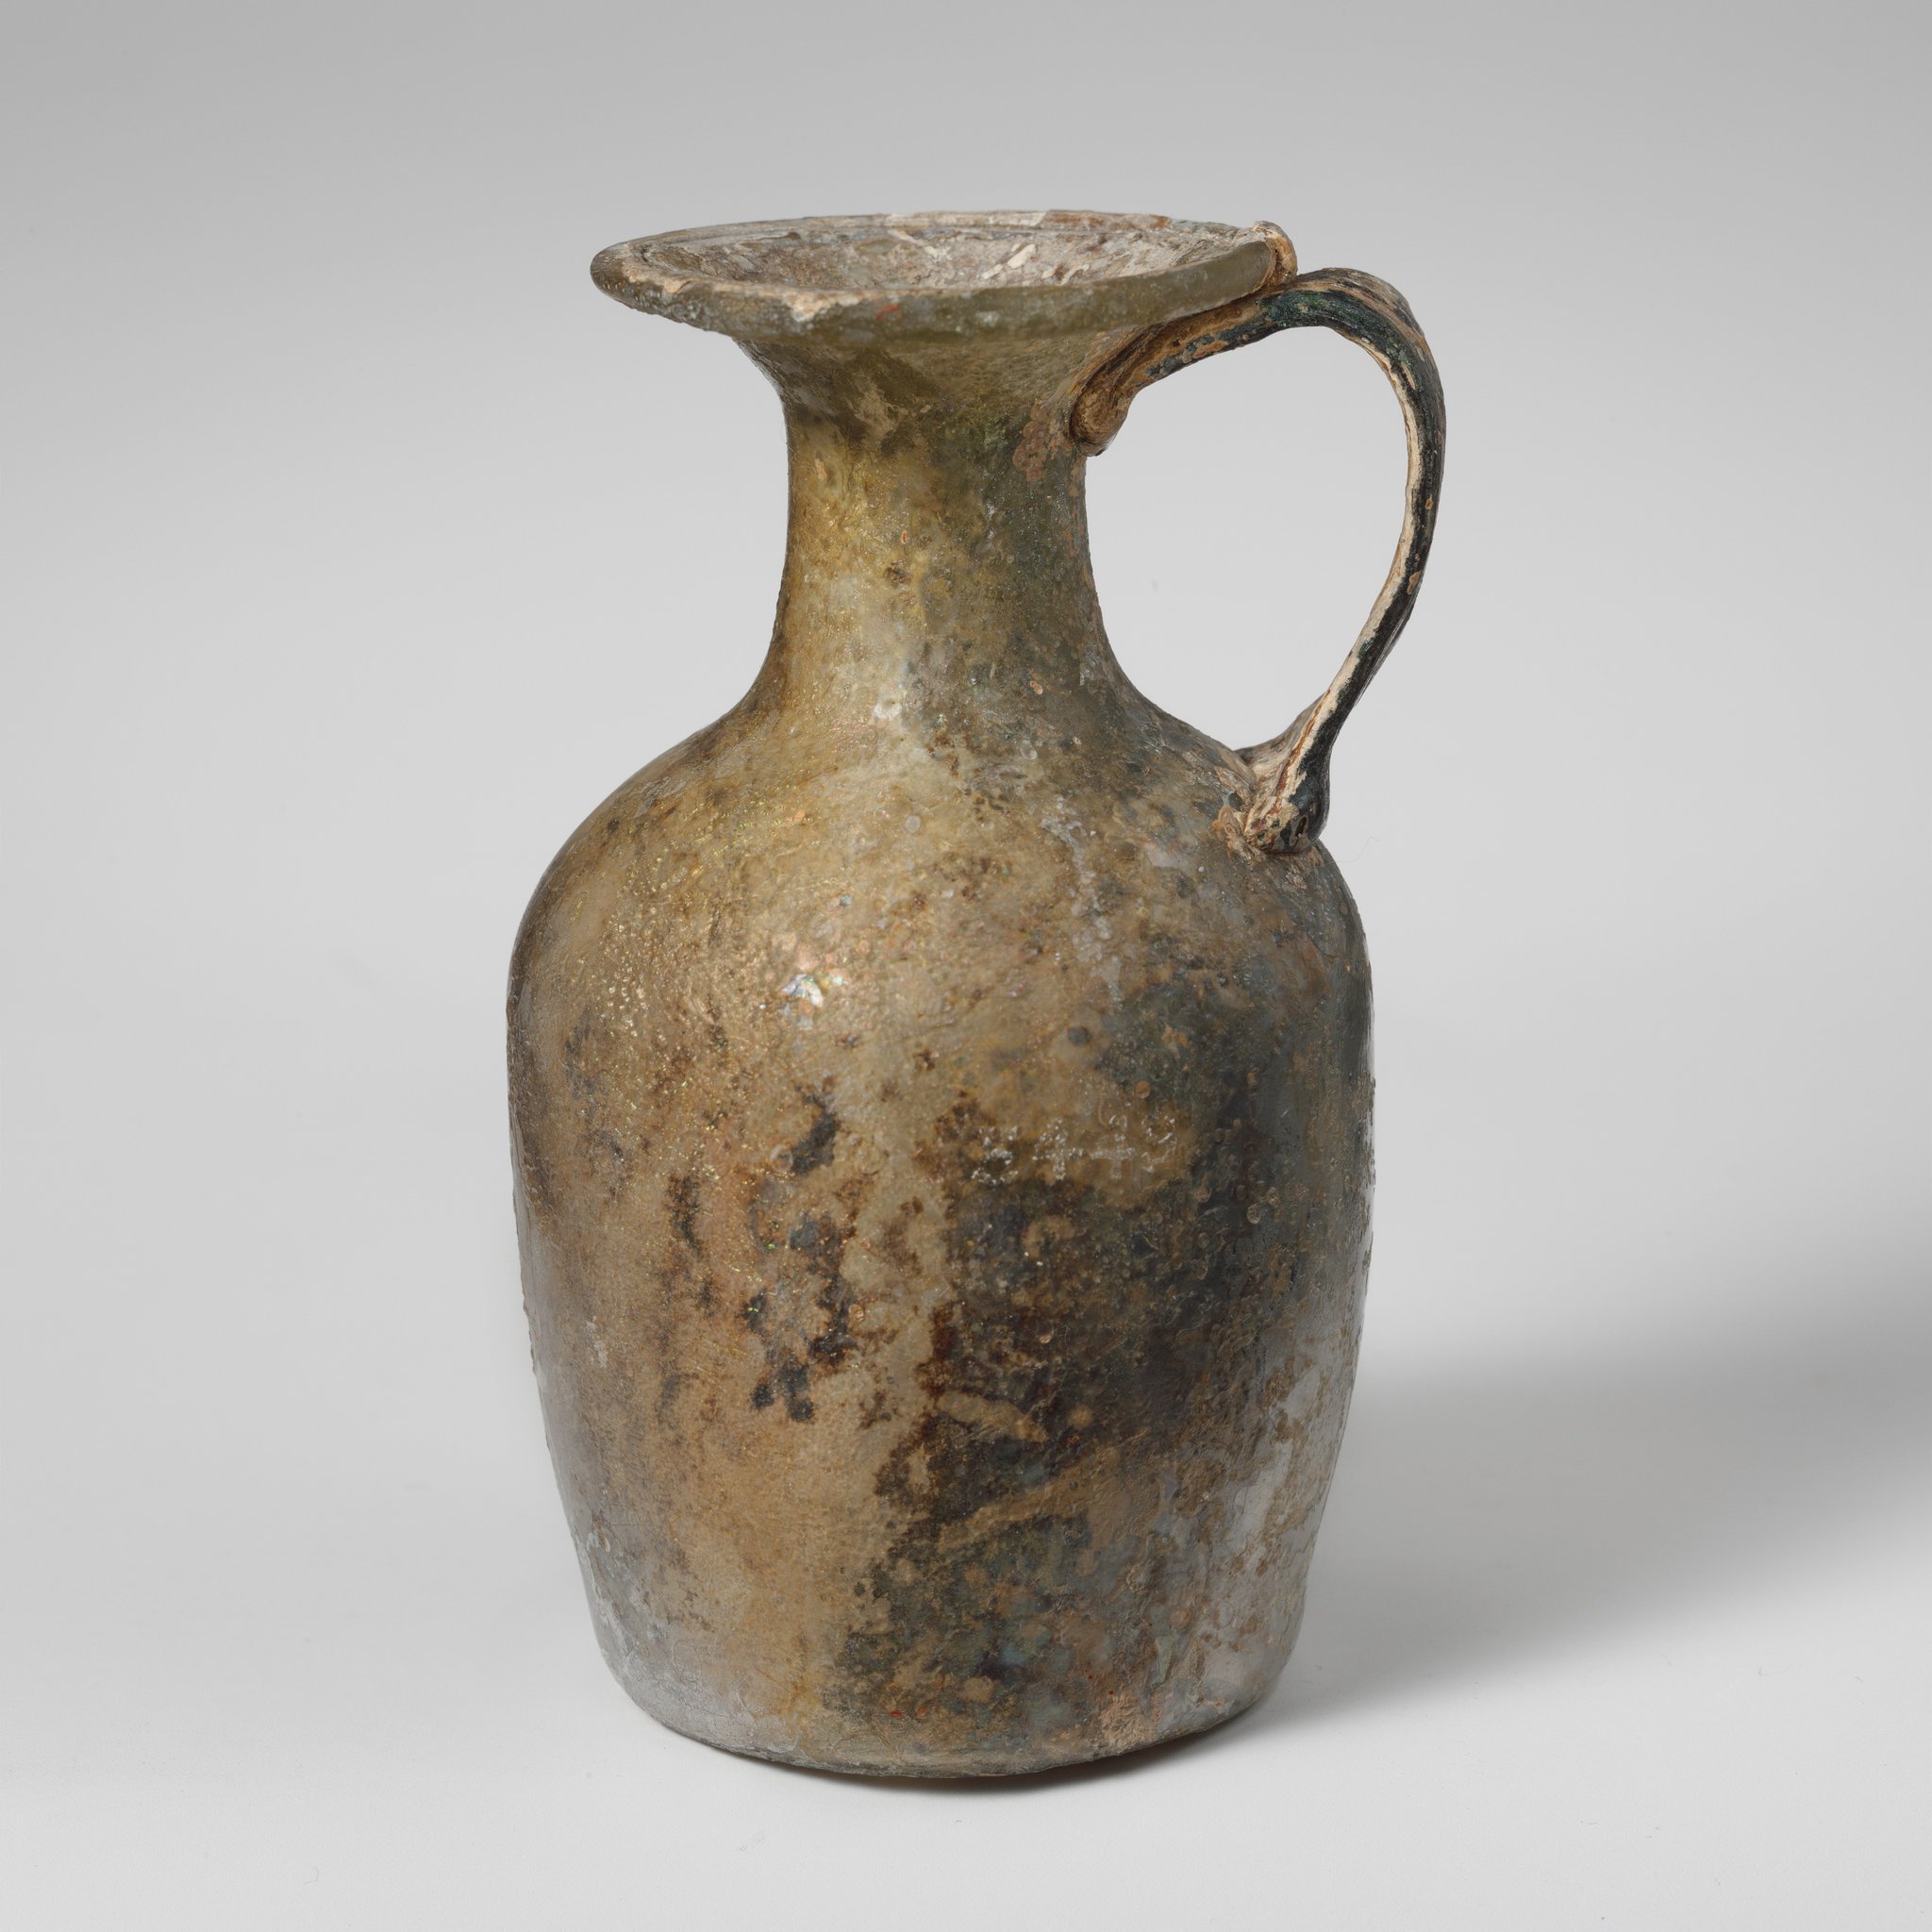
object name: jug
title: Glass jug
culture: roman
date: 201-300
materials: glass